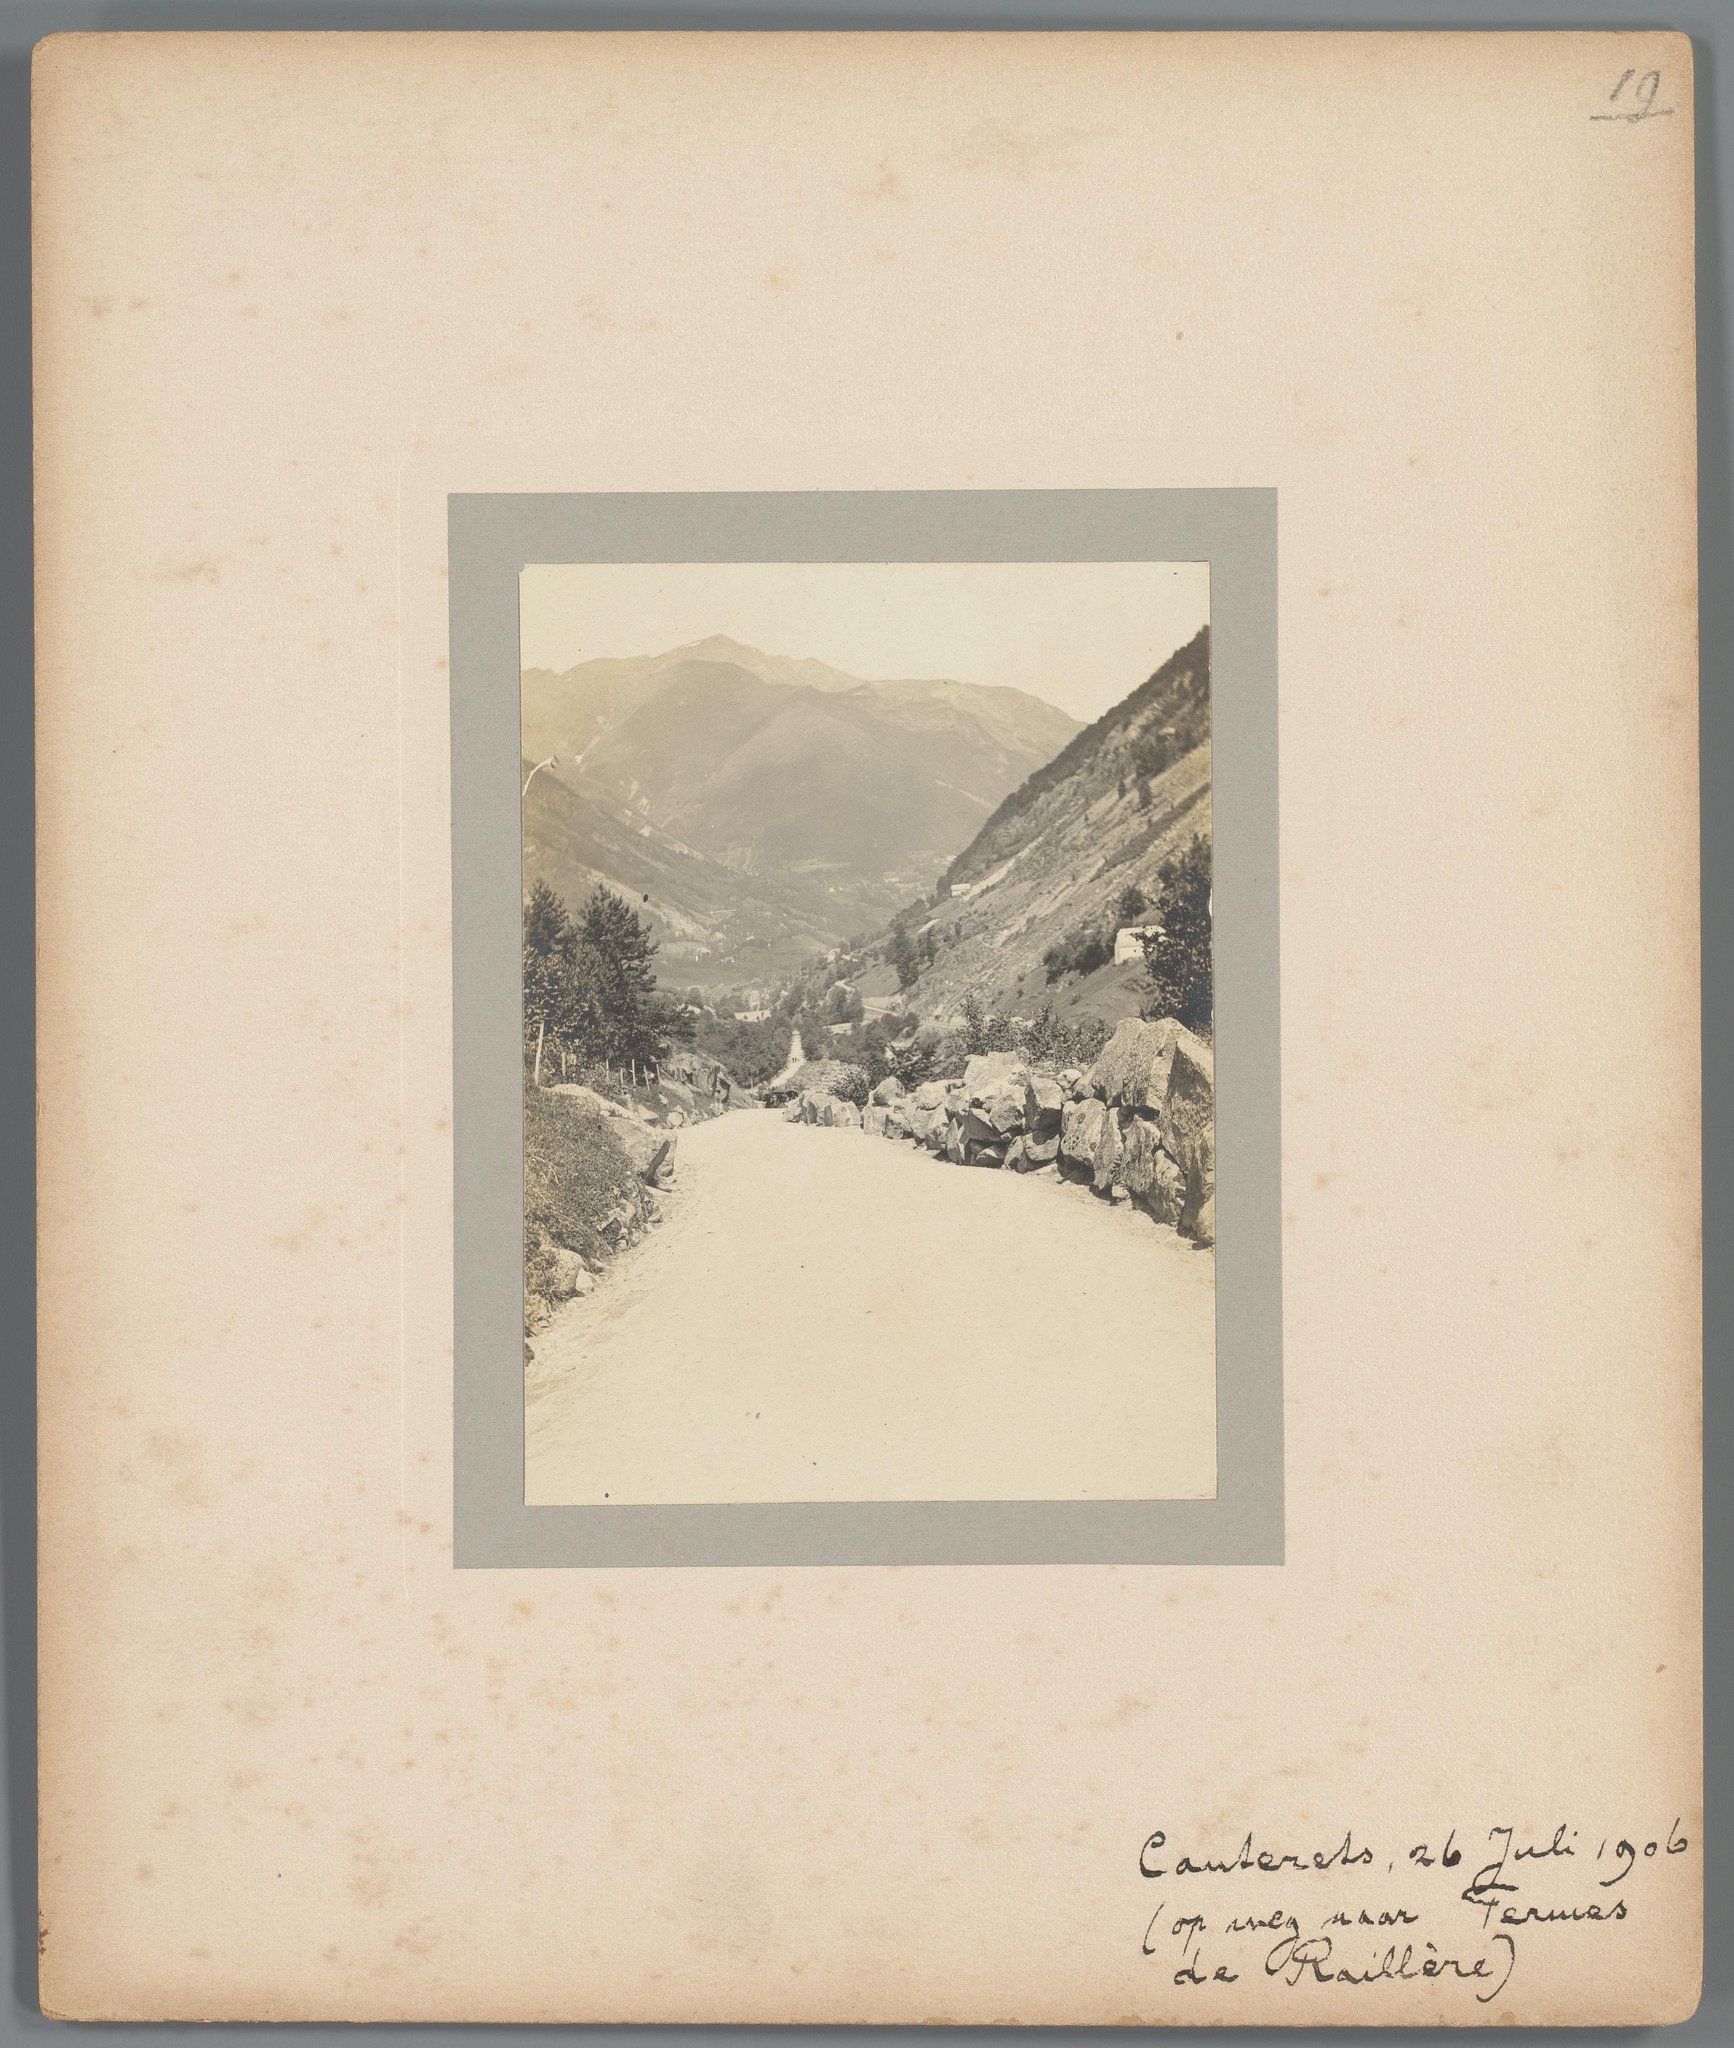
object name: photograph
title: Cauterets (op weg naar Termes de Raillère)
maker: françois buys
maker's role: advocaat, amateurfotograaf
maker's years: 1871-1934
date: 1906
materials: paper, cardboard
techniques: gelatin silver print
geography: cauterets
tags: road, path, mountains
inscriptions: number: ‘19’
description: Deze foto maakt deel uit van een groep van 49 foto's.